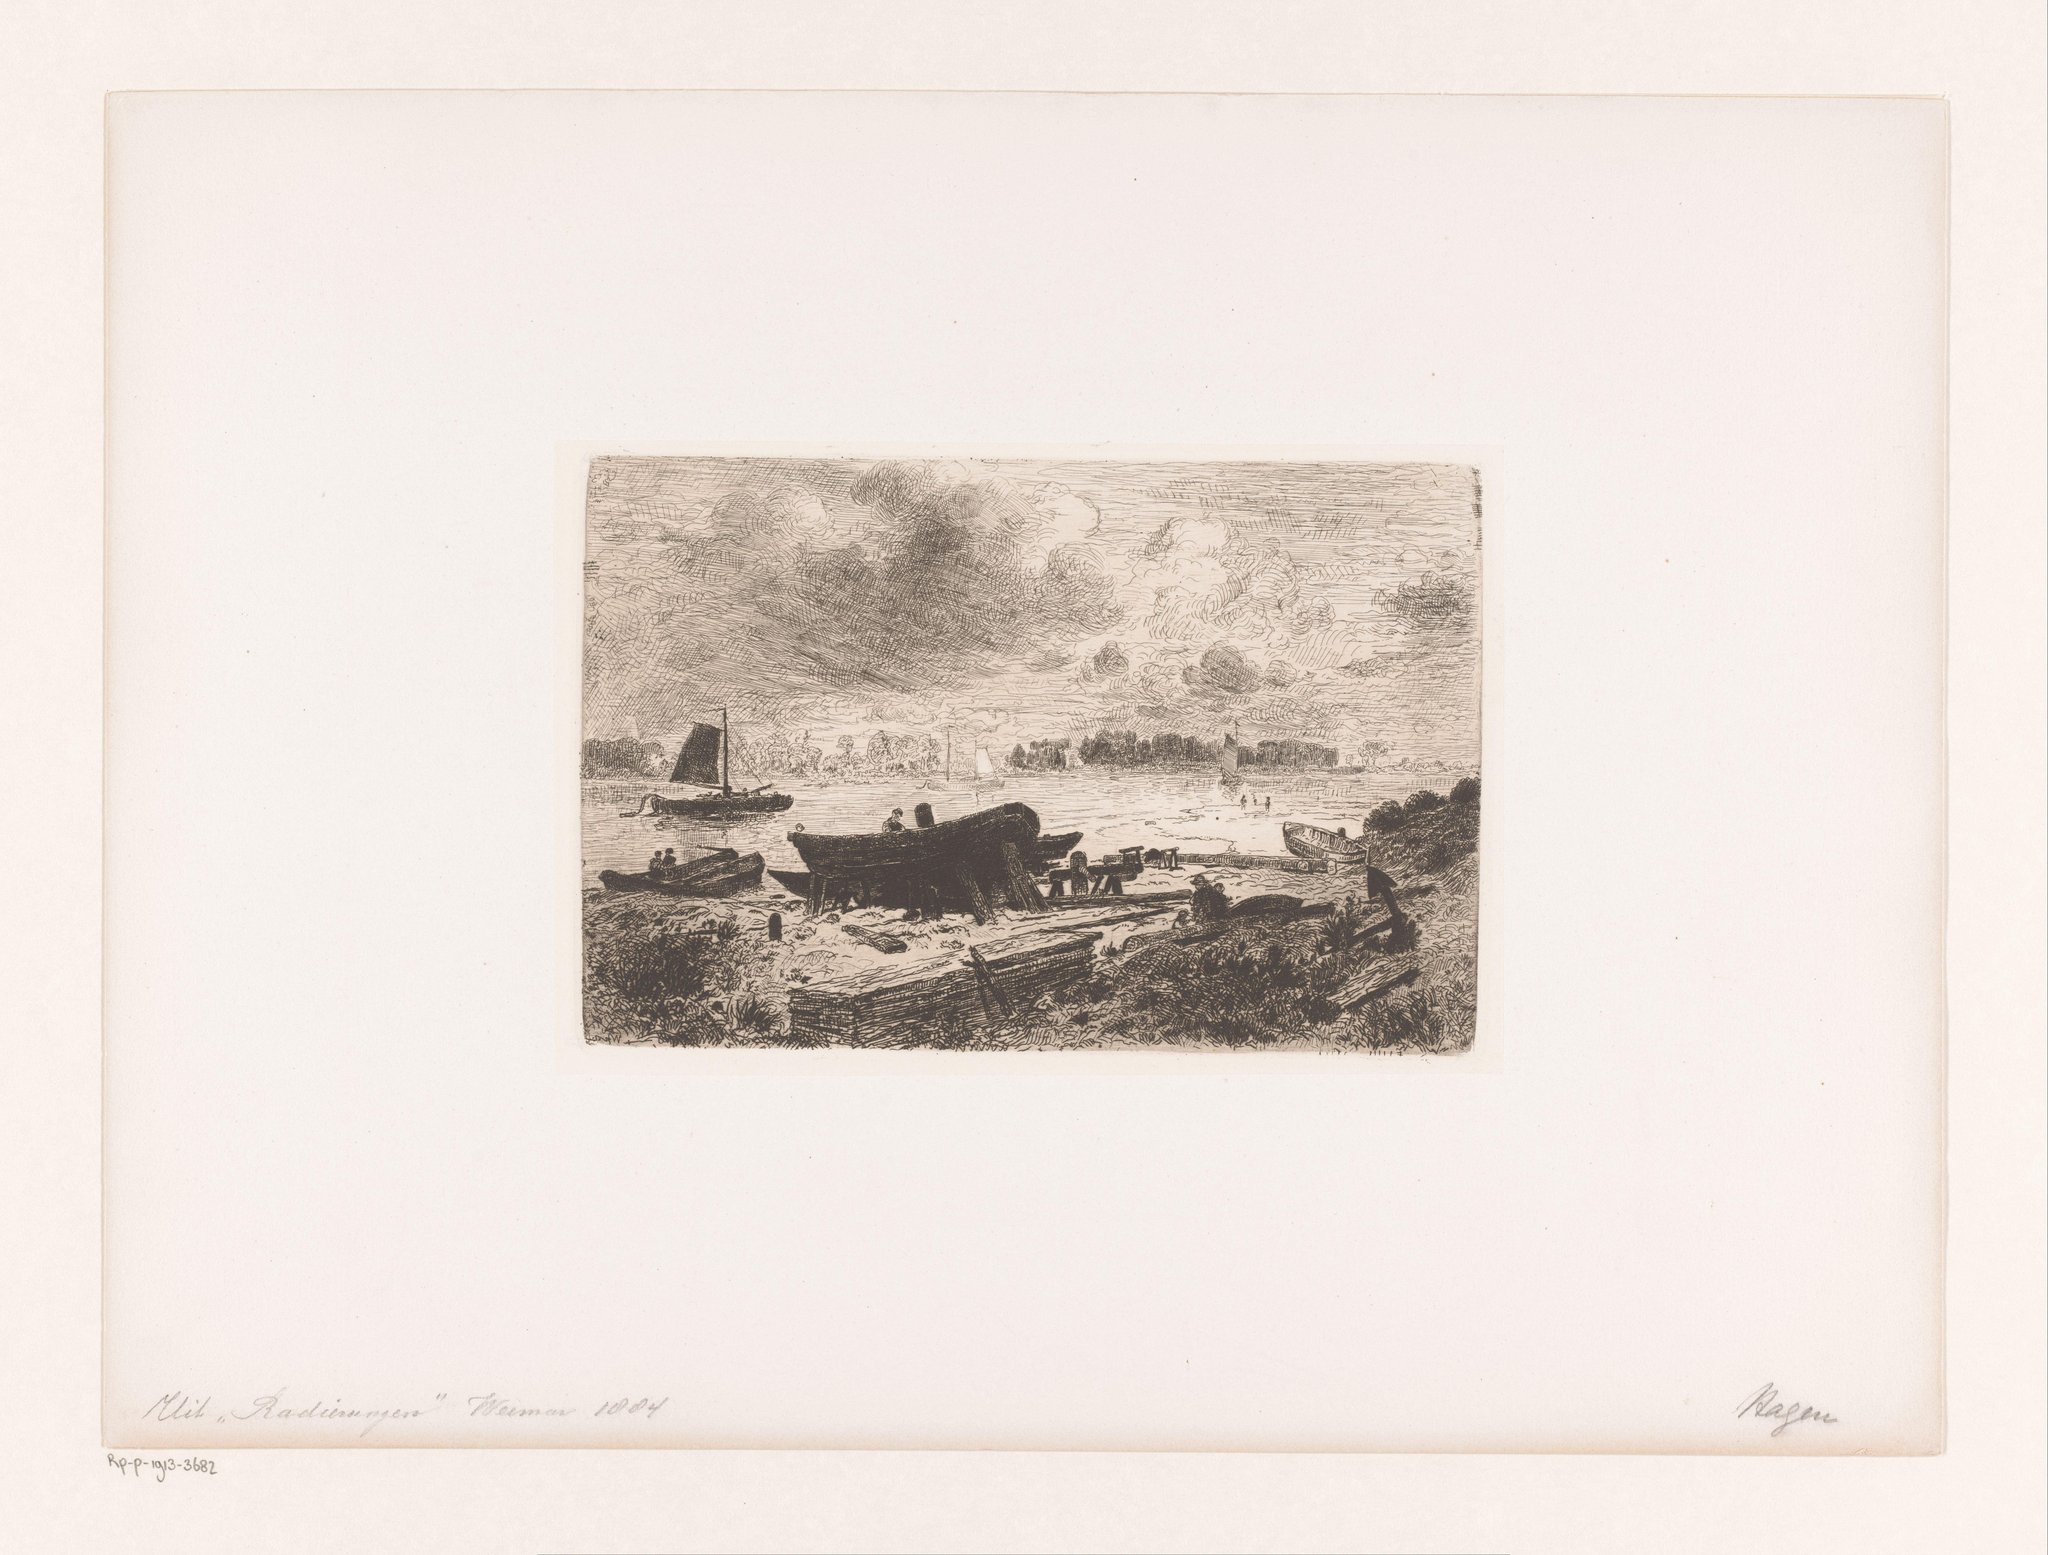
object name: print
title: Rivierlandschap met scheepswerf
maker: theodor hagen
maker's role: print maker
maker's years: 1842-1919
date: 1884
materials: paper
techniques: etching, intaglio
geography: weimar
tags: shipyard, shipdock, river (+ landscape with figures, staffage)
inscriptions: collector's mark: Lugt 2228, inscription: ‘Uit "Radigungen" Weimar 1884’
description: Prent maakt deel uit van een groep prenten die tussen 1880 en 1888 werd uitgegeven door het Gesellschaft für Radierkunst te Weimar.